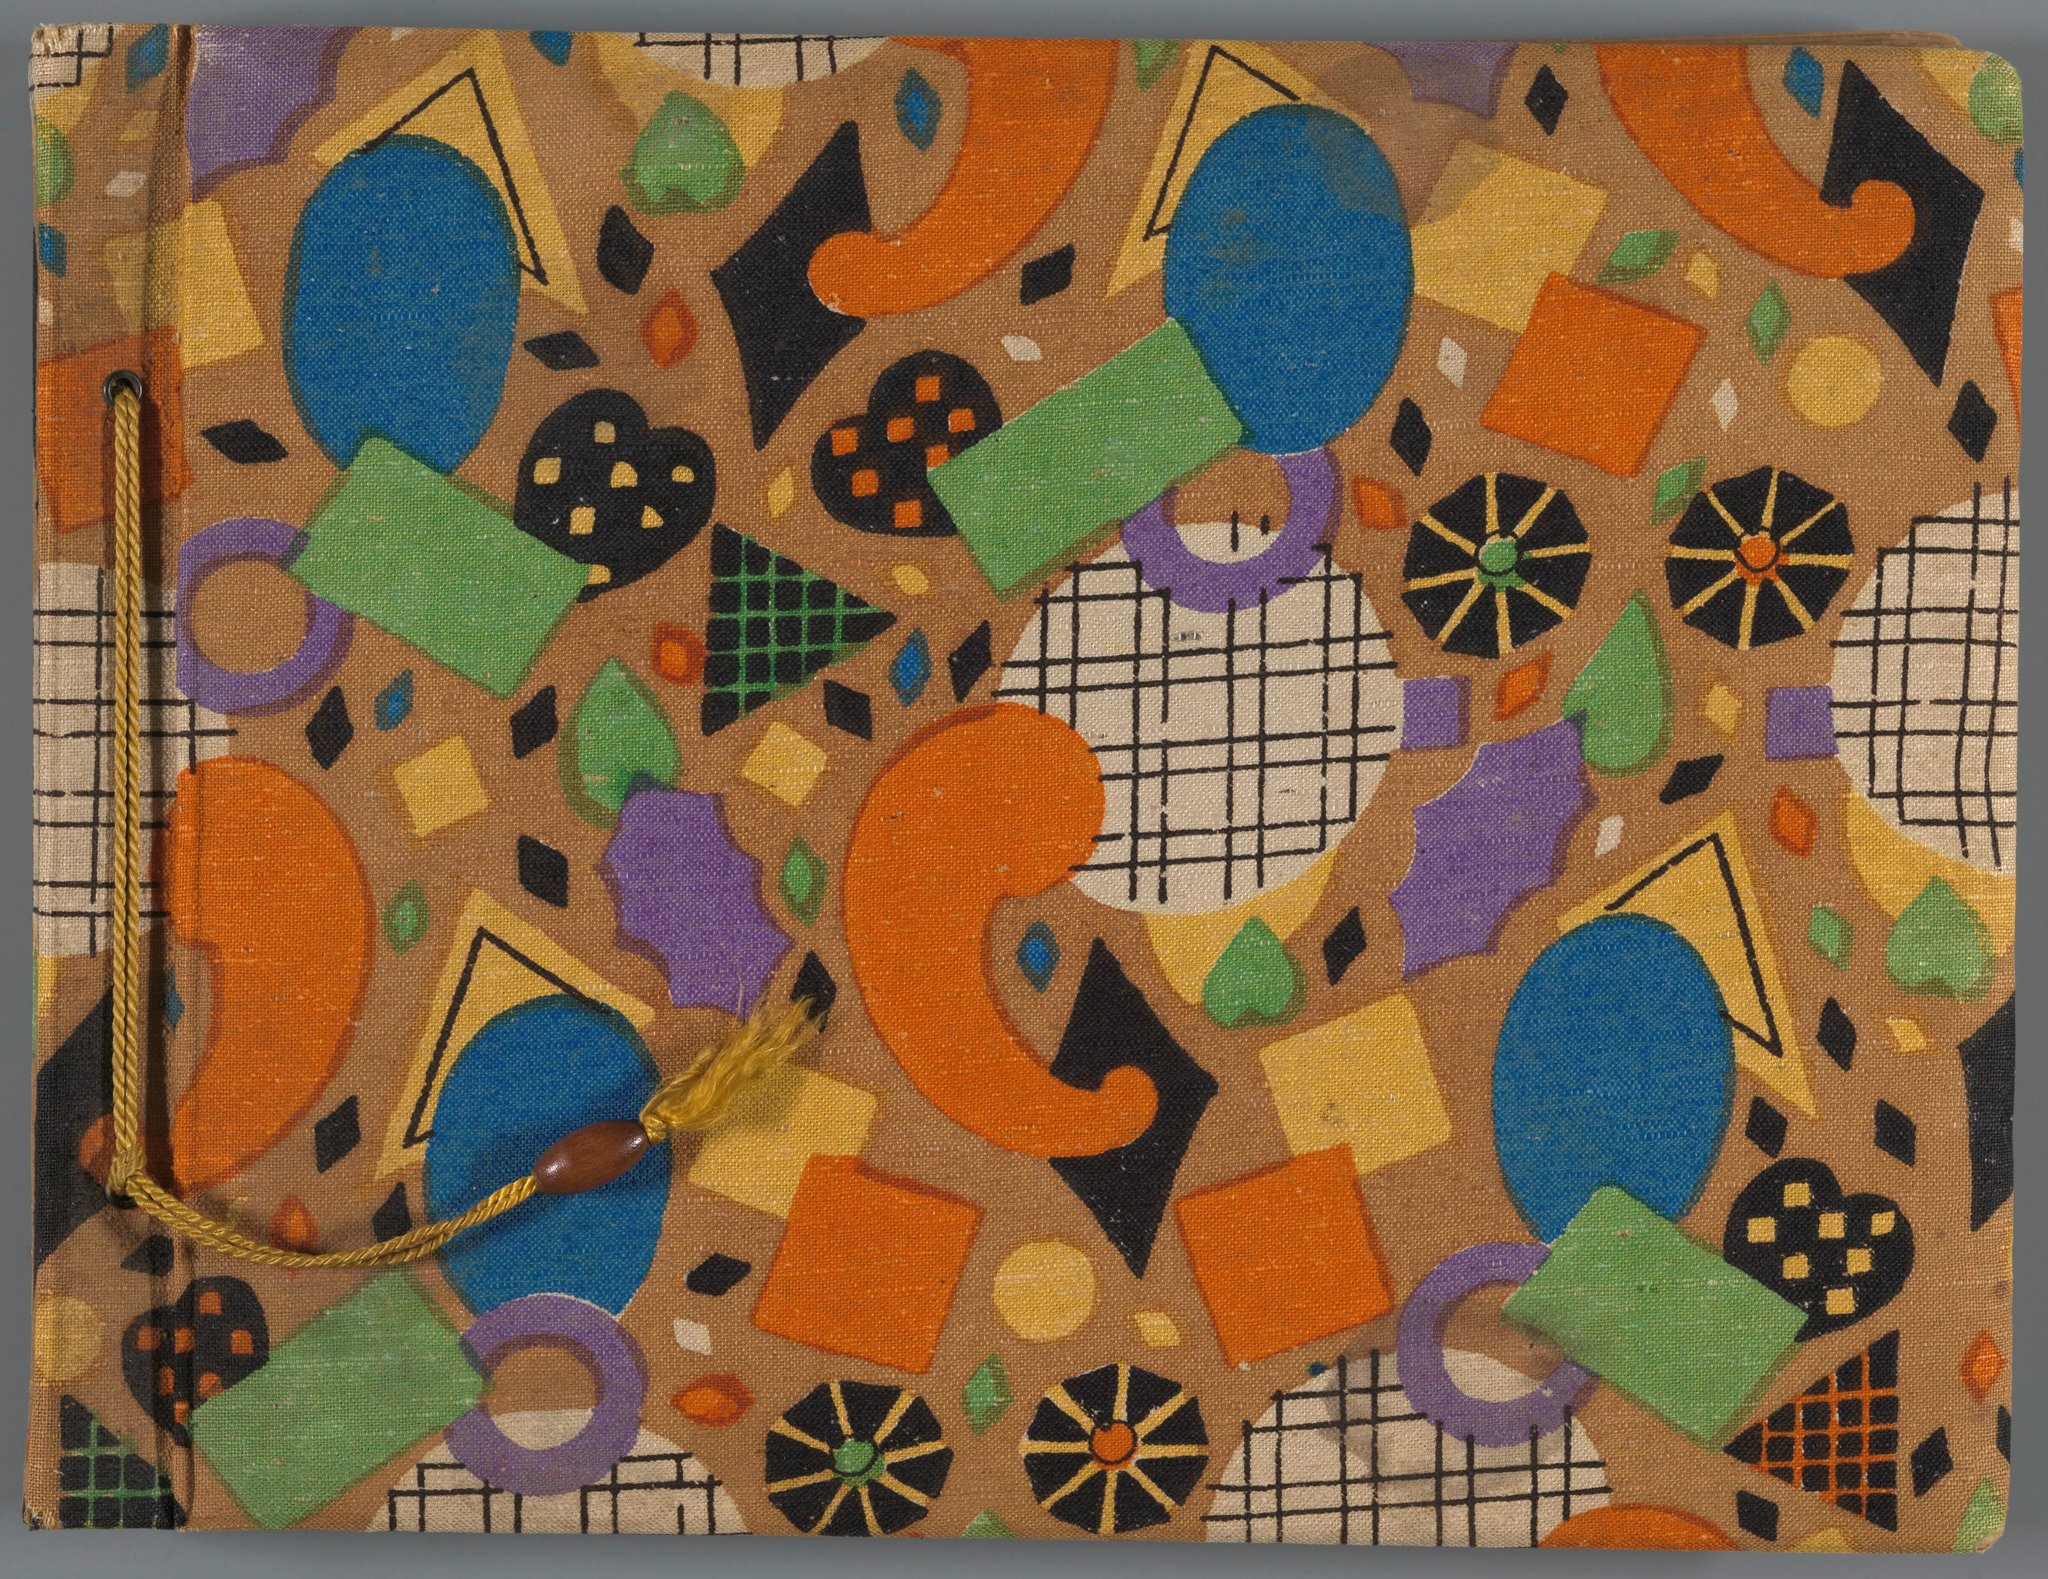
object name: scrapbook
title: Fotoalbum van een onbekende Nederlandse familie met opnames van Suriname, Europa en Nederlands-Indië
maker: Anonymous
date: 1910-1930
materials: cardboard, paper, linen, metal, photographic support, fiber, wood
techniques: albumen print, gelatin silver print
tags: family life, travelling; tourism, suriname, dutch east indies, the, europe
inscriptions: name: ‘Leibag’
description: Fotoalbum in linnen omslag met kleurige geometrische patronen op voor- en achterplat. De bandrug is doorregen met een geel koord met een houten kraal aan het uiteinde. Het album heeft 24 door pergamijnvellen gescheiden kartonnen bladen. Daarop zijn 126 foto's geplakt, 3 foto's werden los in het album aangetroffen. Het album maakt deel uit van een serie van drie bij elkaar horende familiealbums: RP-F-F01202, RP-F-F01203 en RP-F-F01204. De meeste foto's in het onderhavige album hebben een handgeschreven, Nederlandstalig onderschrift en zijn doorgaans door amateurfotografen gemaakt. In het album bevinden zich enkele afdrukken die identiek zijn aan die in album RP-F-F01202 en RP-F-F01204. Centrale figuur in het album is een onbekende vrouw die (vermoedelijk) ook de onderschriften maakte. Daarin verwijst zij regelmatig naar zichzelf, zoals bijvoorbeeld bij foto RP-F-F01203-CM "hoe ik er uitzag in 1917". Zij verbleef blijkens de foto's behalve in Nederland, ook in Suriname en in Nederlands-Indië waar zij deel uitmaakte van het koloniale establishment. In beeld zijn onder meer gebracht de opening van de Lawaspoorlijn (Landsspoorweg) in Paramaribo in 1905 en de onthulling van een standbeeld van koningin Wilhelmina op het Gouvernementsplein te Paramaribo in 1923. Voorts opnames van het huiselijke - en familieleven op de plantages ''t Vertrouwen', 'La liberté', en buitenplaats 'Veldlust' en van ontmoetingen, uitstapjes en reizen met vrienden en bekenden. De in de onderschriften genoemde namen zijn 'Terlaak', 'Janschen', 'Ottenhof', 'Carpentier en Dempsey', 'Friedel' en 'Mientje'.